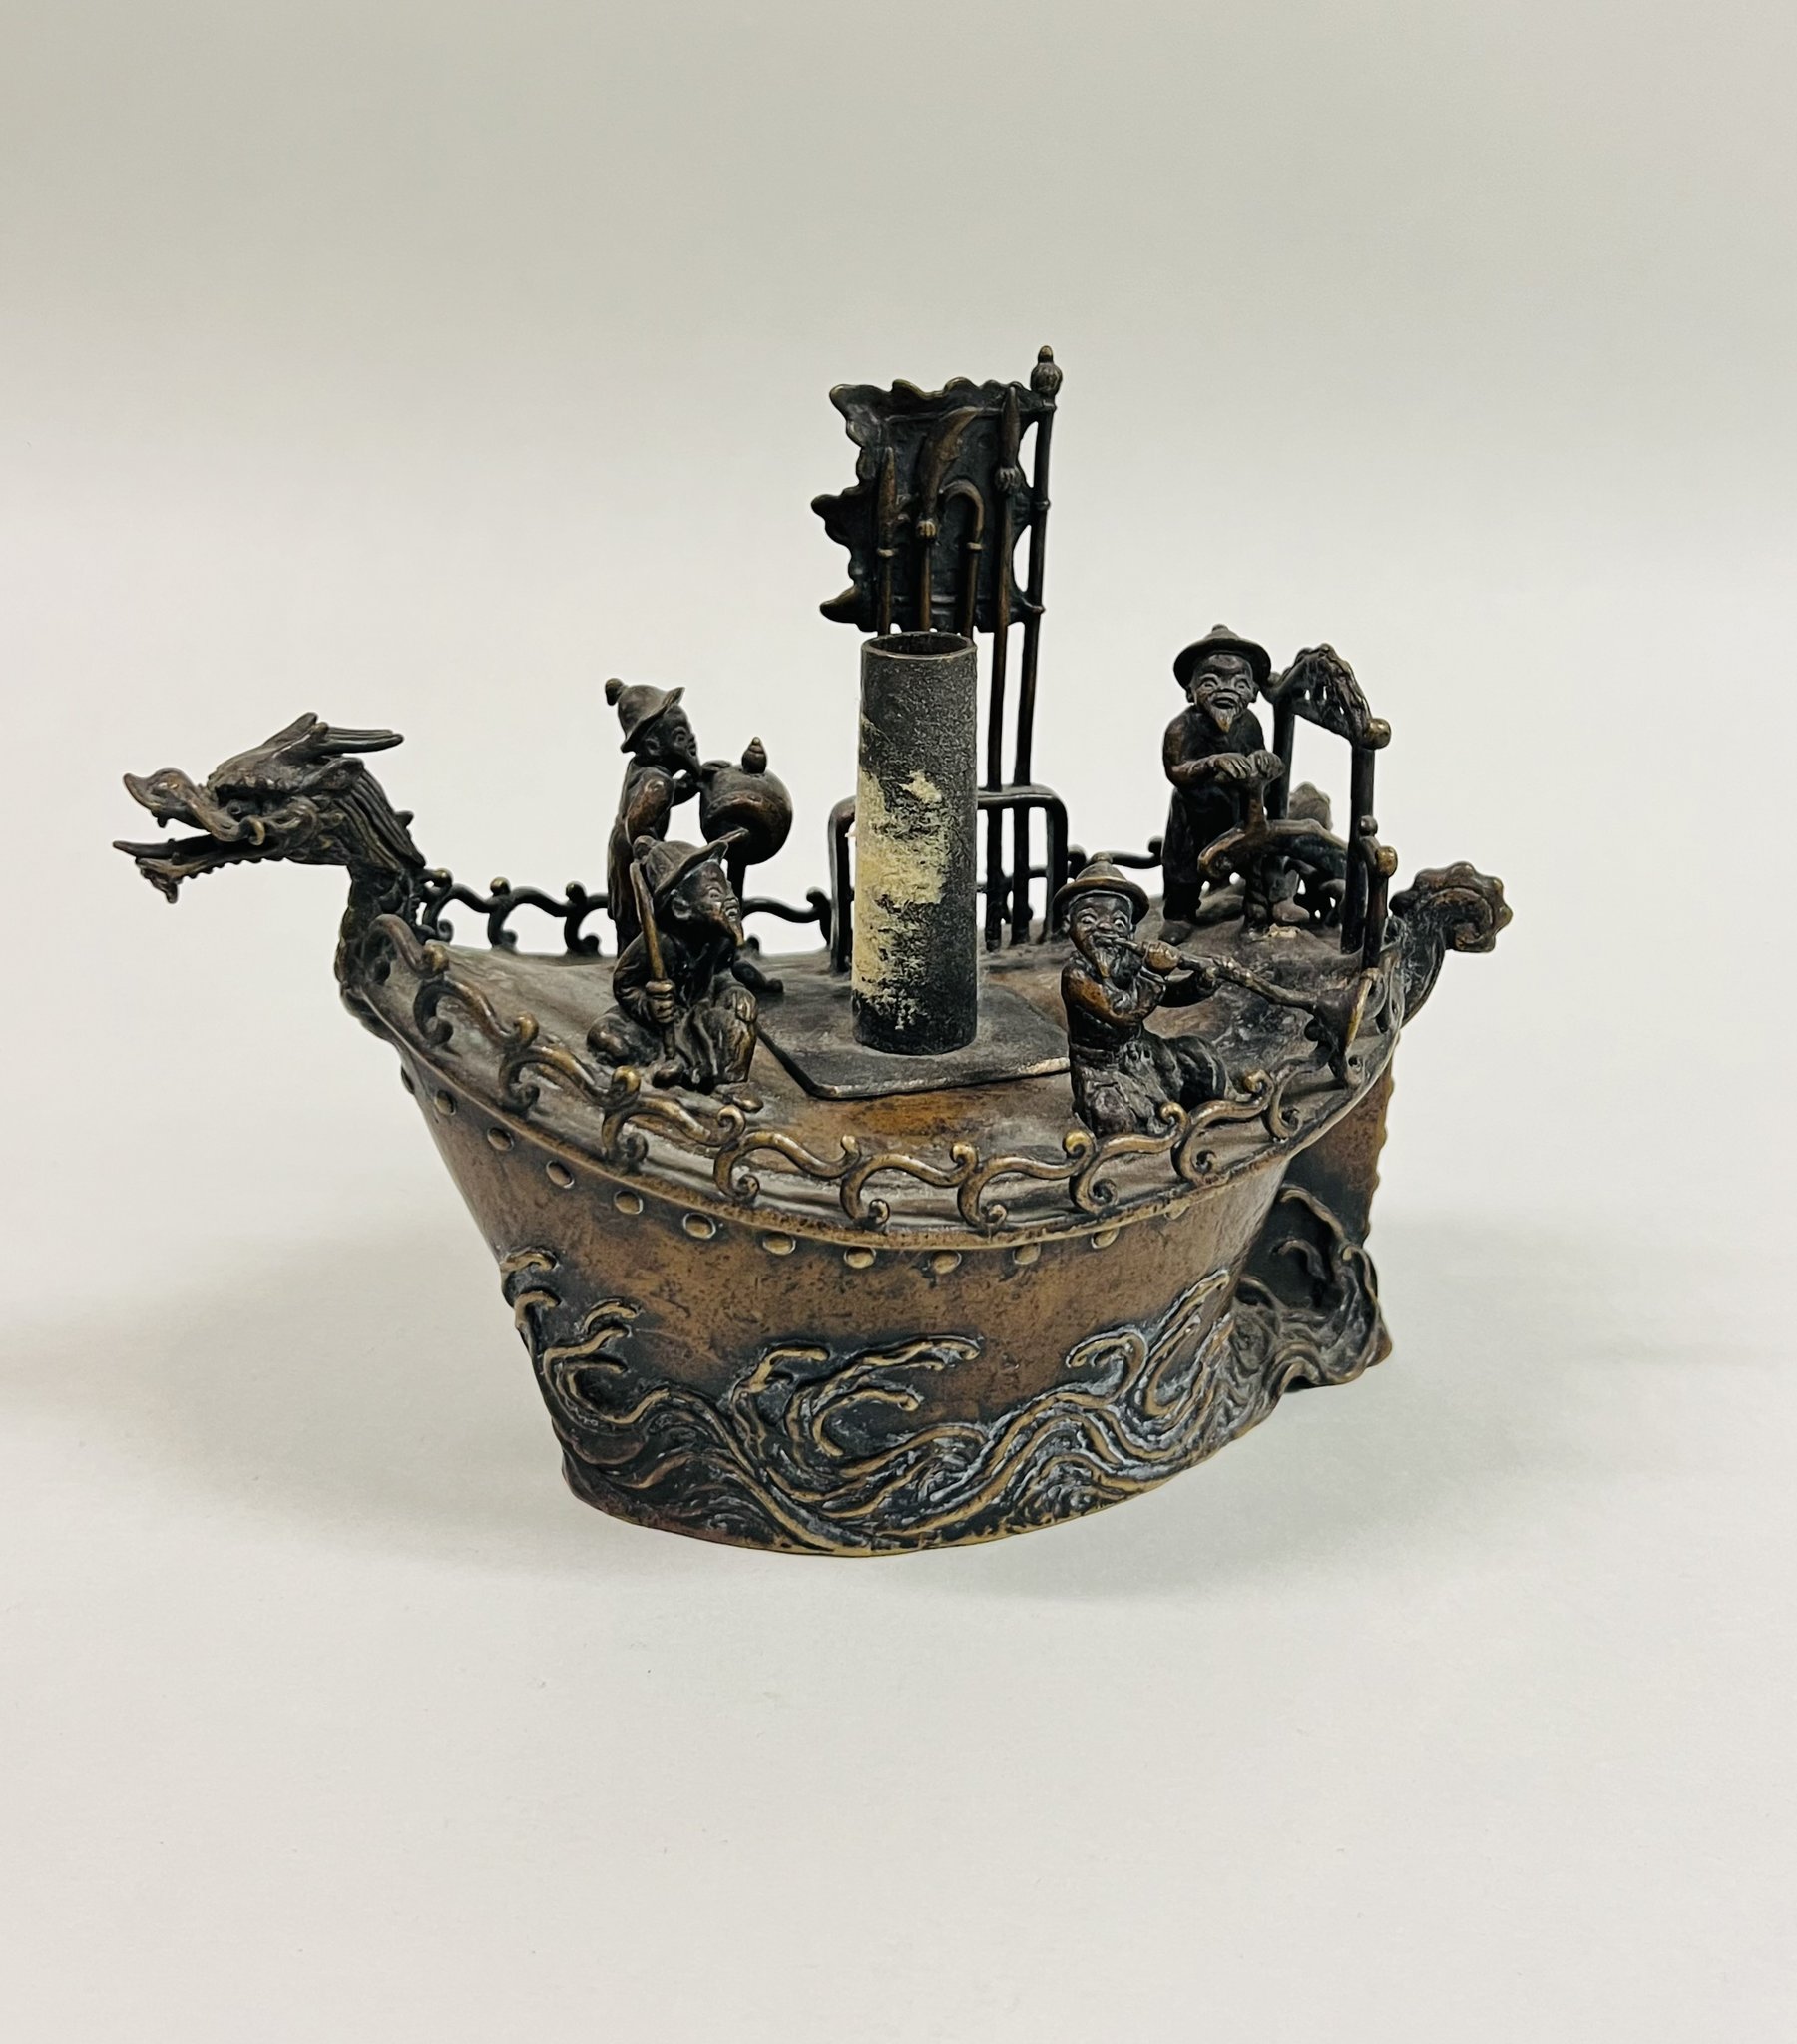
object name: incense burner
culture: chinese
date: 1801-1900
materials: bronze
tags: musical instruments,men